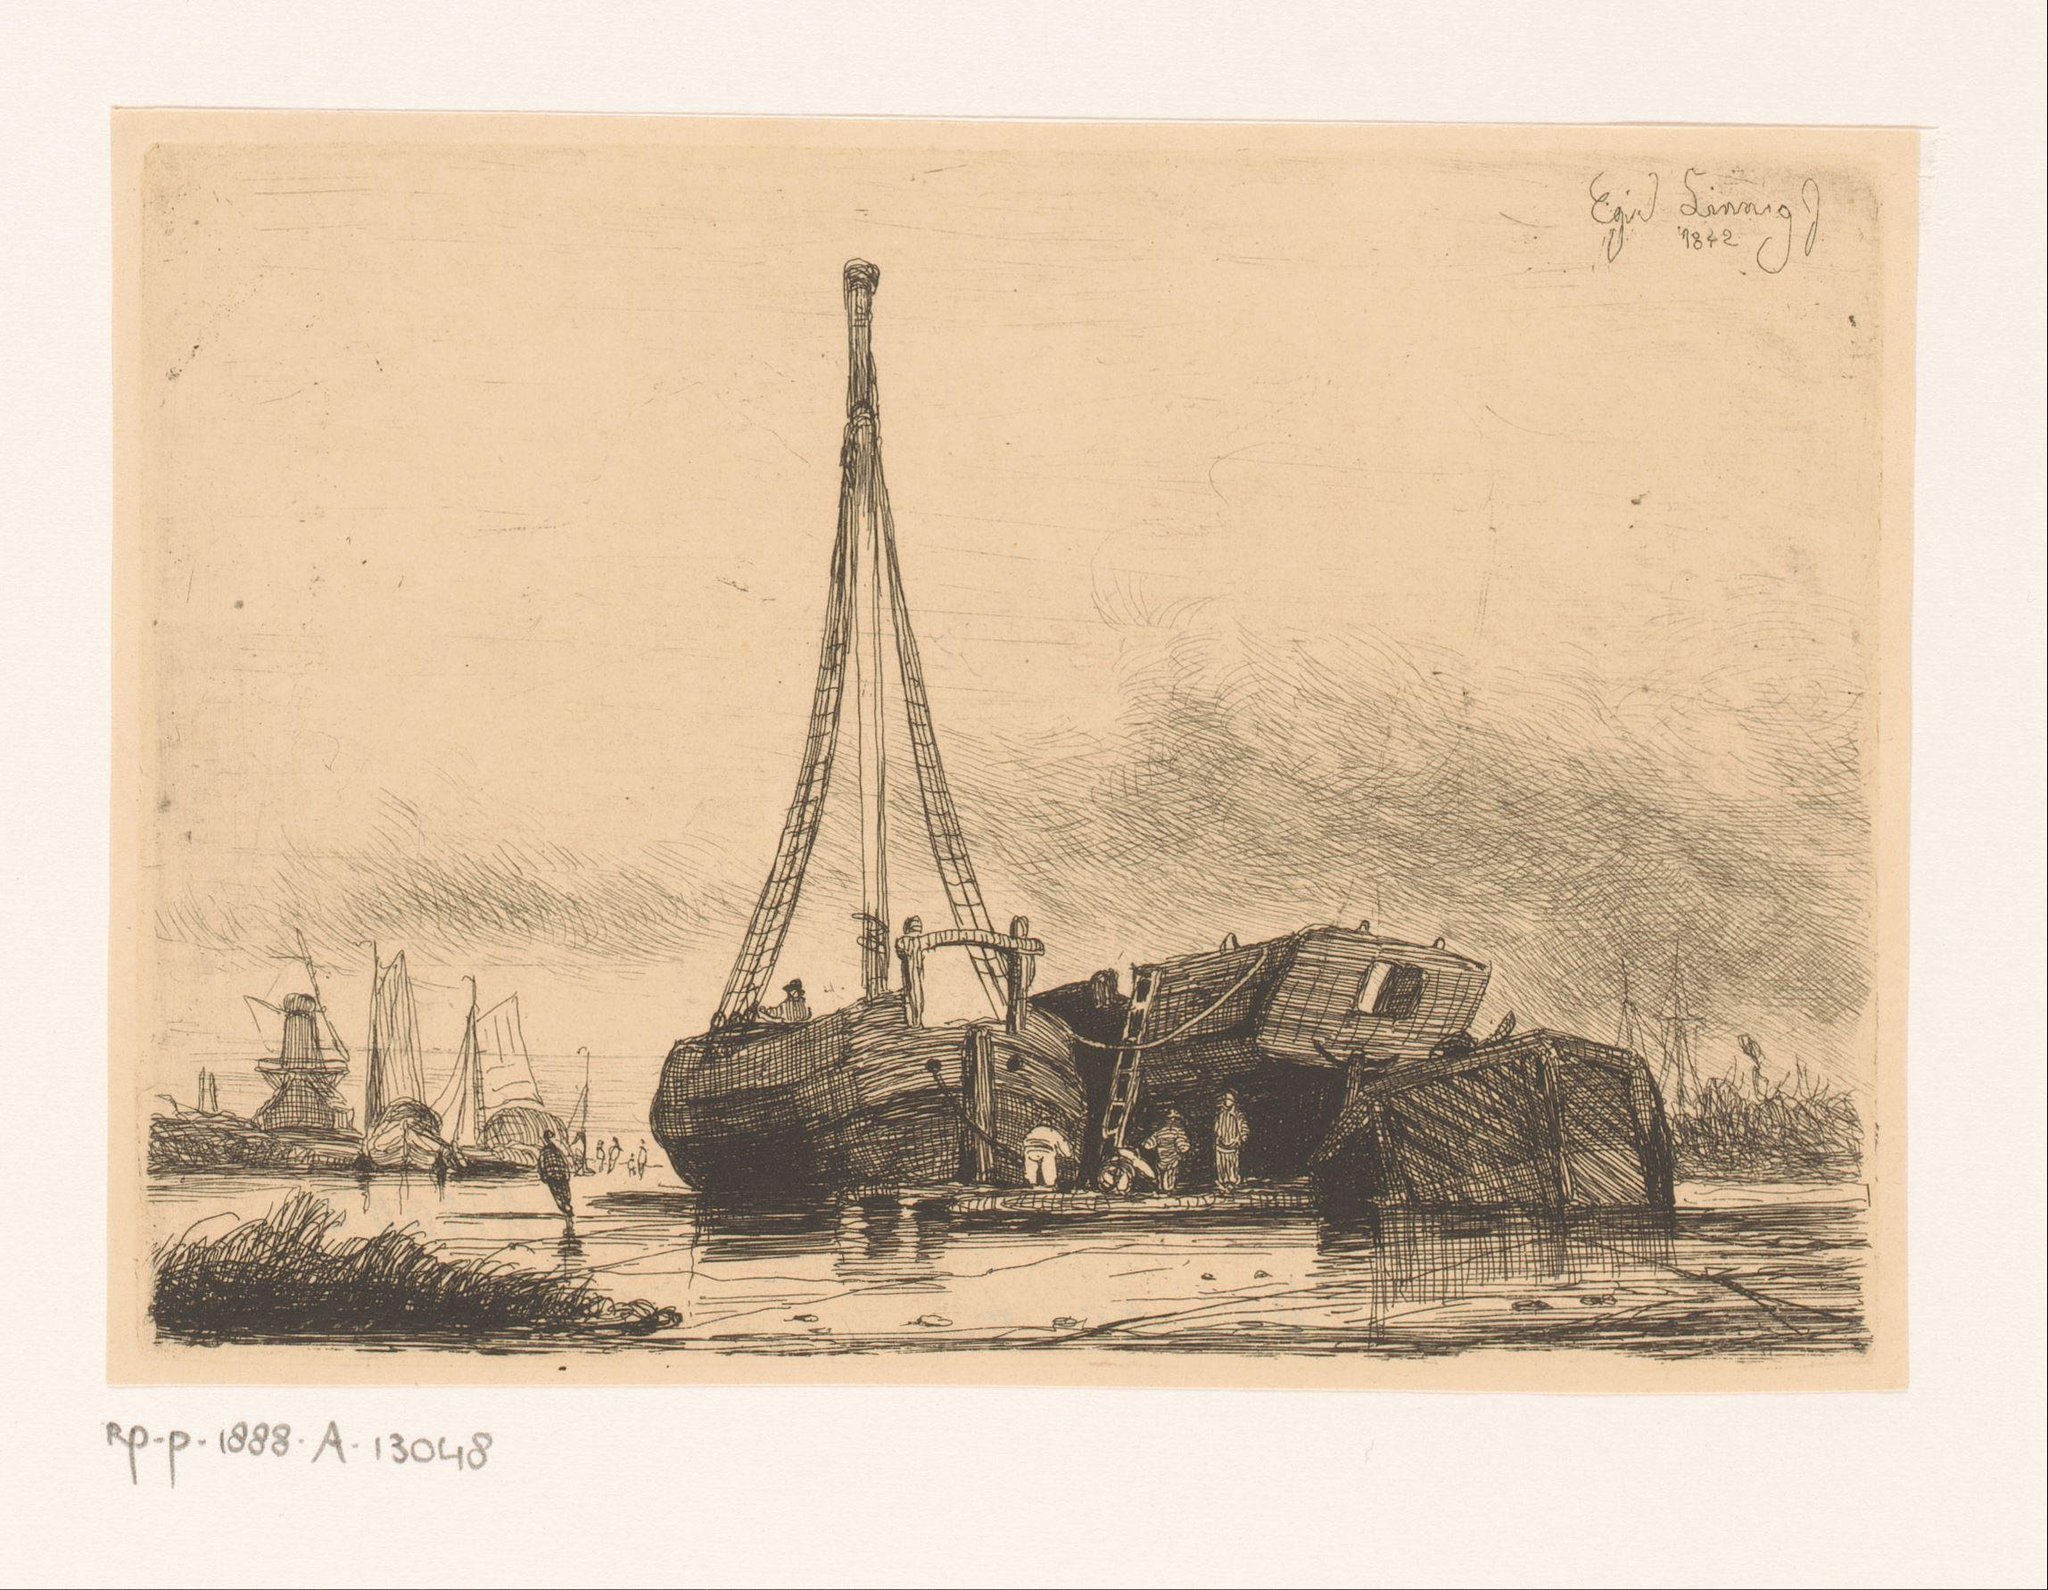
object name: print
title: Kanonneerboten in het dok bij Antwerpen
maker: egidius linnig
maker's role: draughtsman, print maker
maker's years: 1821-1860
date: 1842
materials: paper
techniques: etching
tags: sailing-ship, sailing-boat, dry-dock, floating-dock, antwerp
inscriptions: collector's mark: Lugt 2228